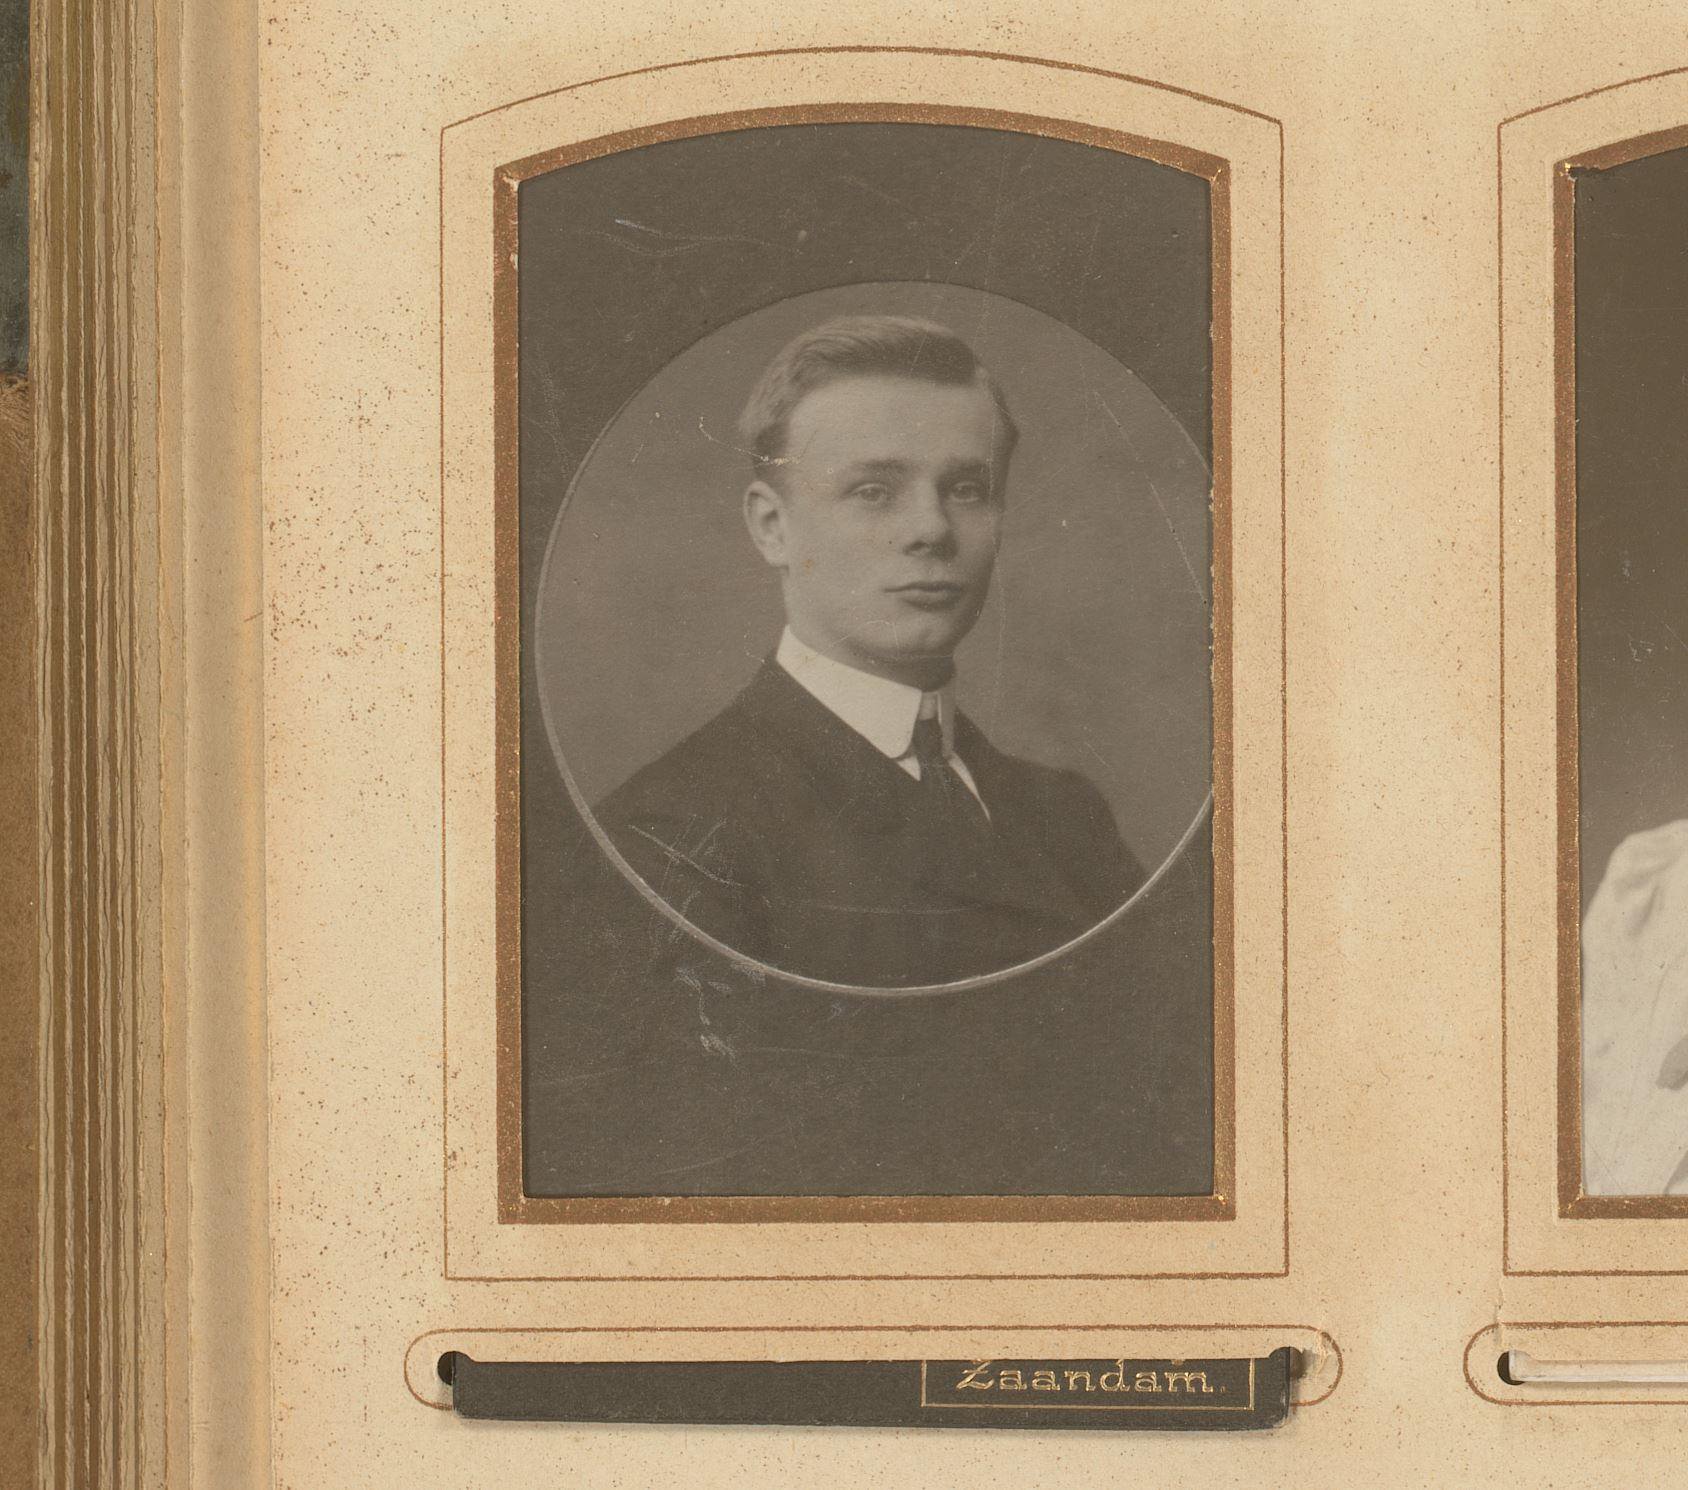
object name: photograph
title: Portret van een jongeman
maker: adriaan boer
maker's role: fotograaf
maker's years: 1875-1940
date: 1909-1931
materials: cardboard, photographic support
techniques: collodion silver print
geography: netherlands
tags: historical persons, youth, adolescent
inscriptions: inscription: ‘Fotografie artistique/ P. Saaf/ Ged. Gracht Nr.8/ Telefoon 65/ Zaandam’, inscription: ‘P. Saaf/ Zaandam’